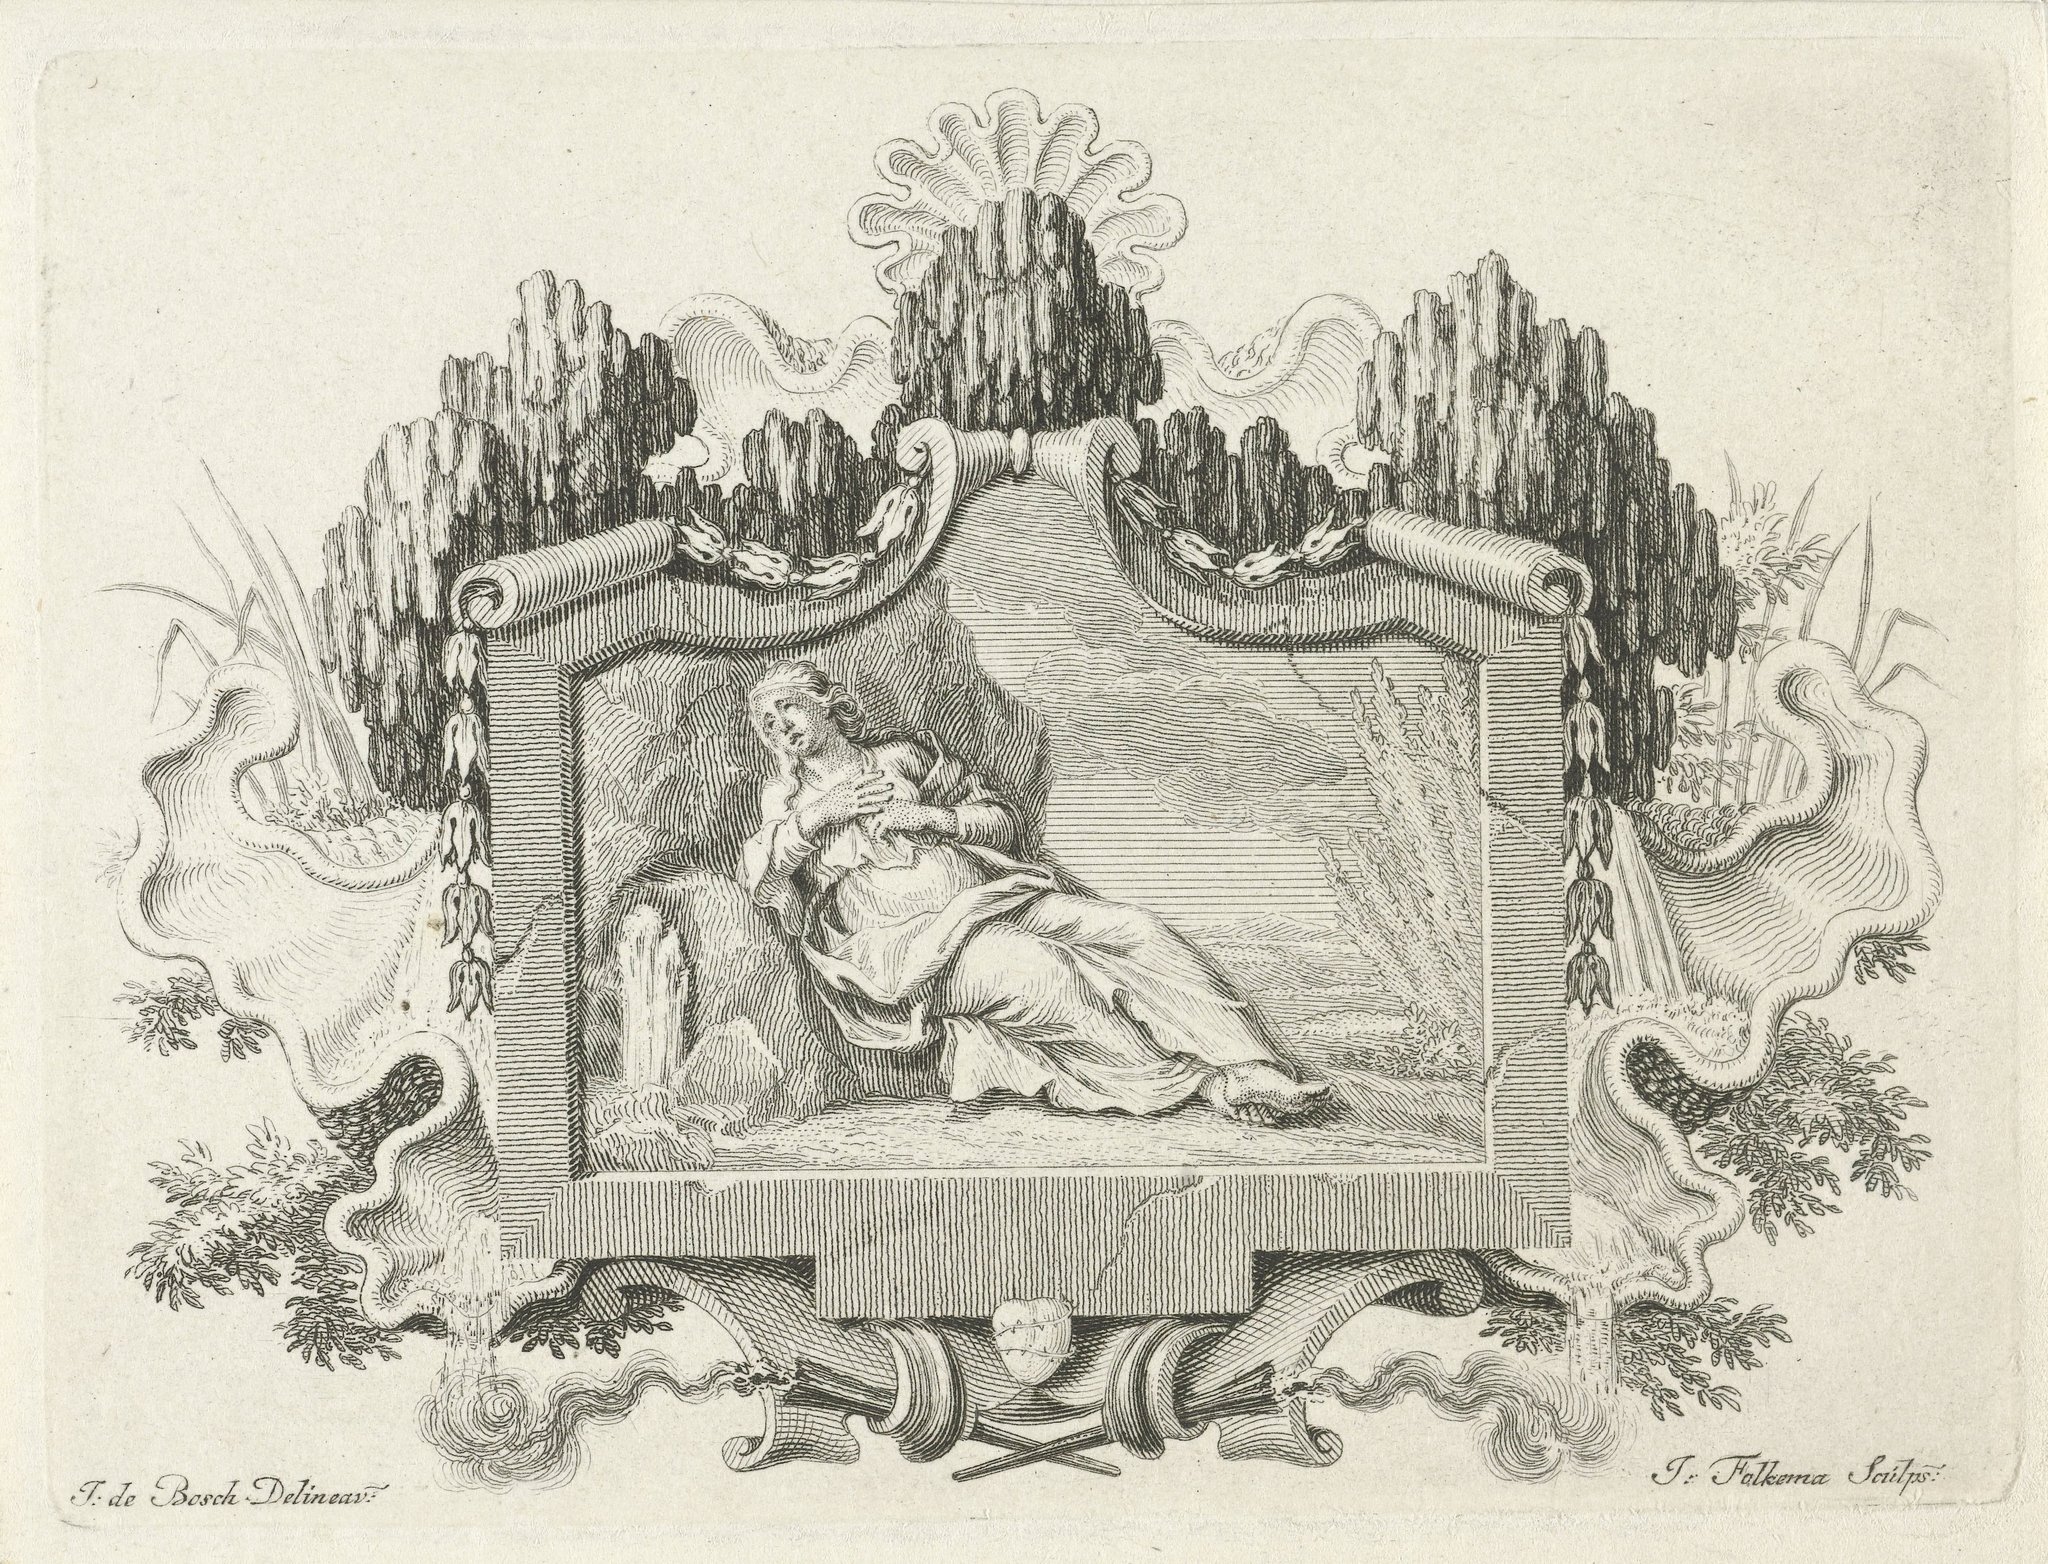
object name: print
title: Deugden en ondeugden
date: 1723-1767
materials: paper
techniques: etching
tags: penance, 'poenitentia'; 'contritione' (ripa) ~ part of the confession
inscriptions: collector's mark: Lugt 240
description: Vignet met de beeltenis van de gepersonifieerde Boetvaardigheid in een ornamentele omlijsting. De lijst is opgebouwd uit een cartouche en schelppatronen, geheel onderaan is een met prikkeldraad omwonden hart weergegeven. De Boetvaardigheid leunt tegen een steen en houdt haar handen op haar borst terwijl ze berouwvol omhoog kijkt. De prent maakt deel uit van een reeks boekillustraties over deugden en ondeugden.